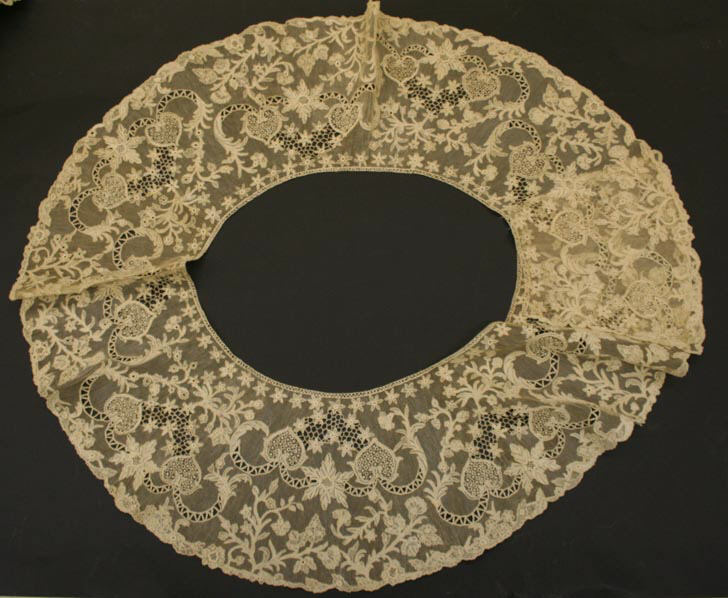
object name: bertha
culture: italian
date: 1801-1900